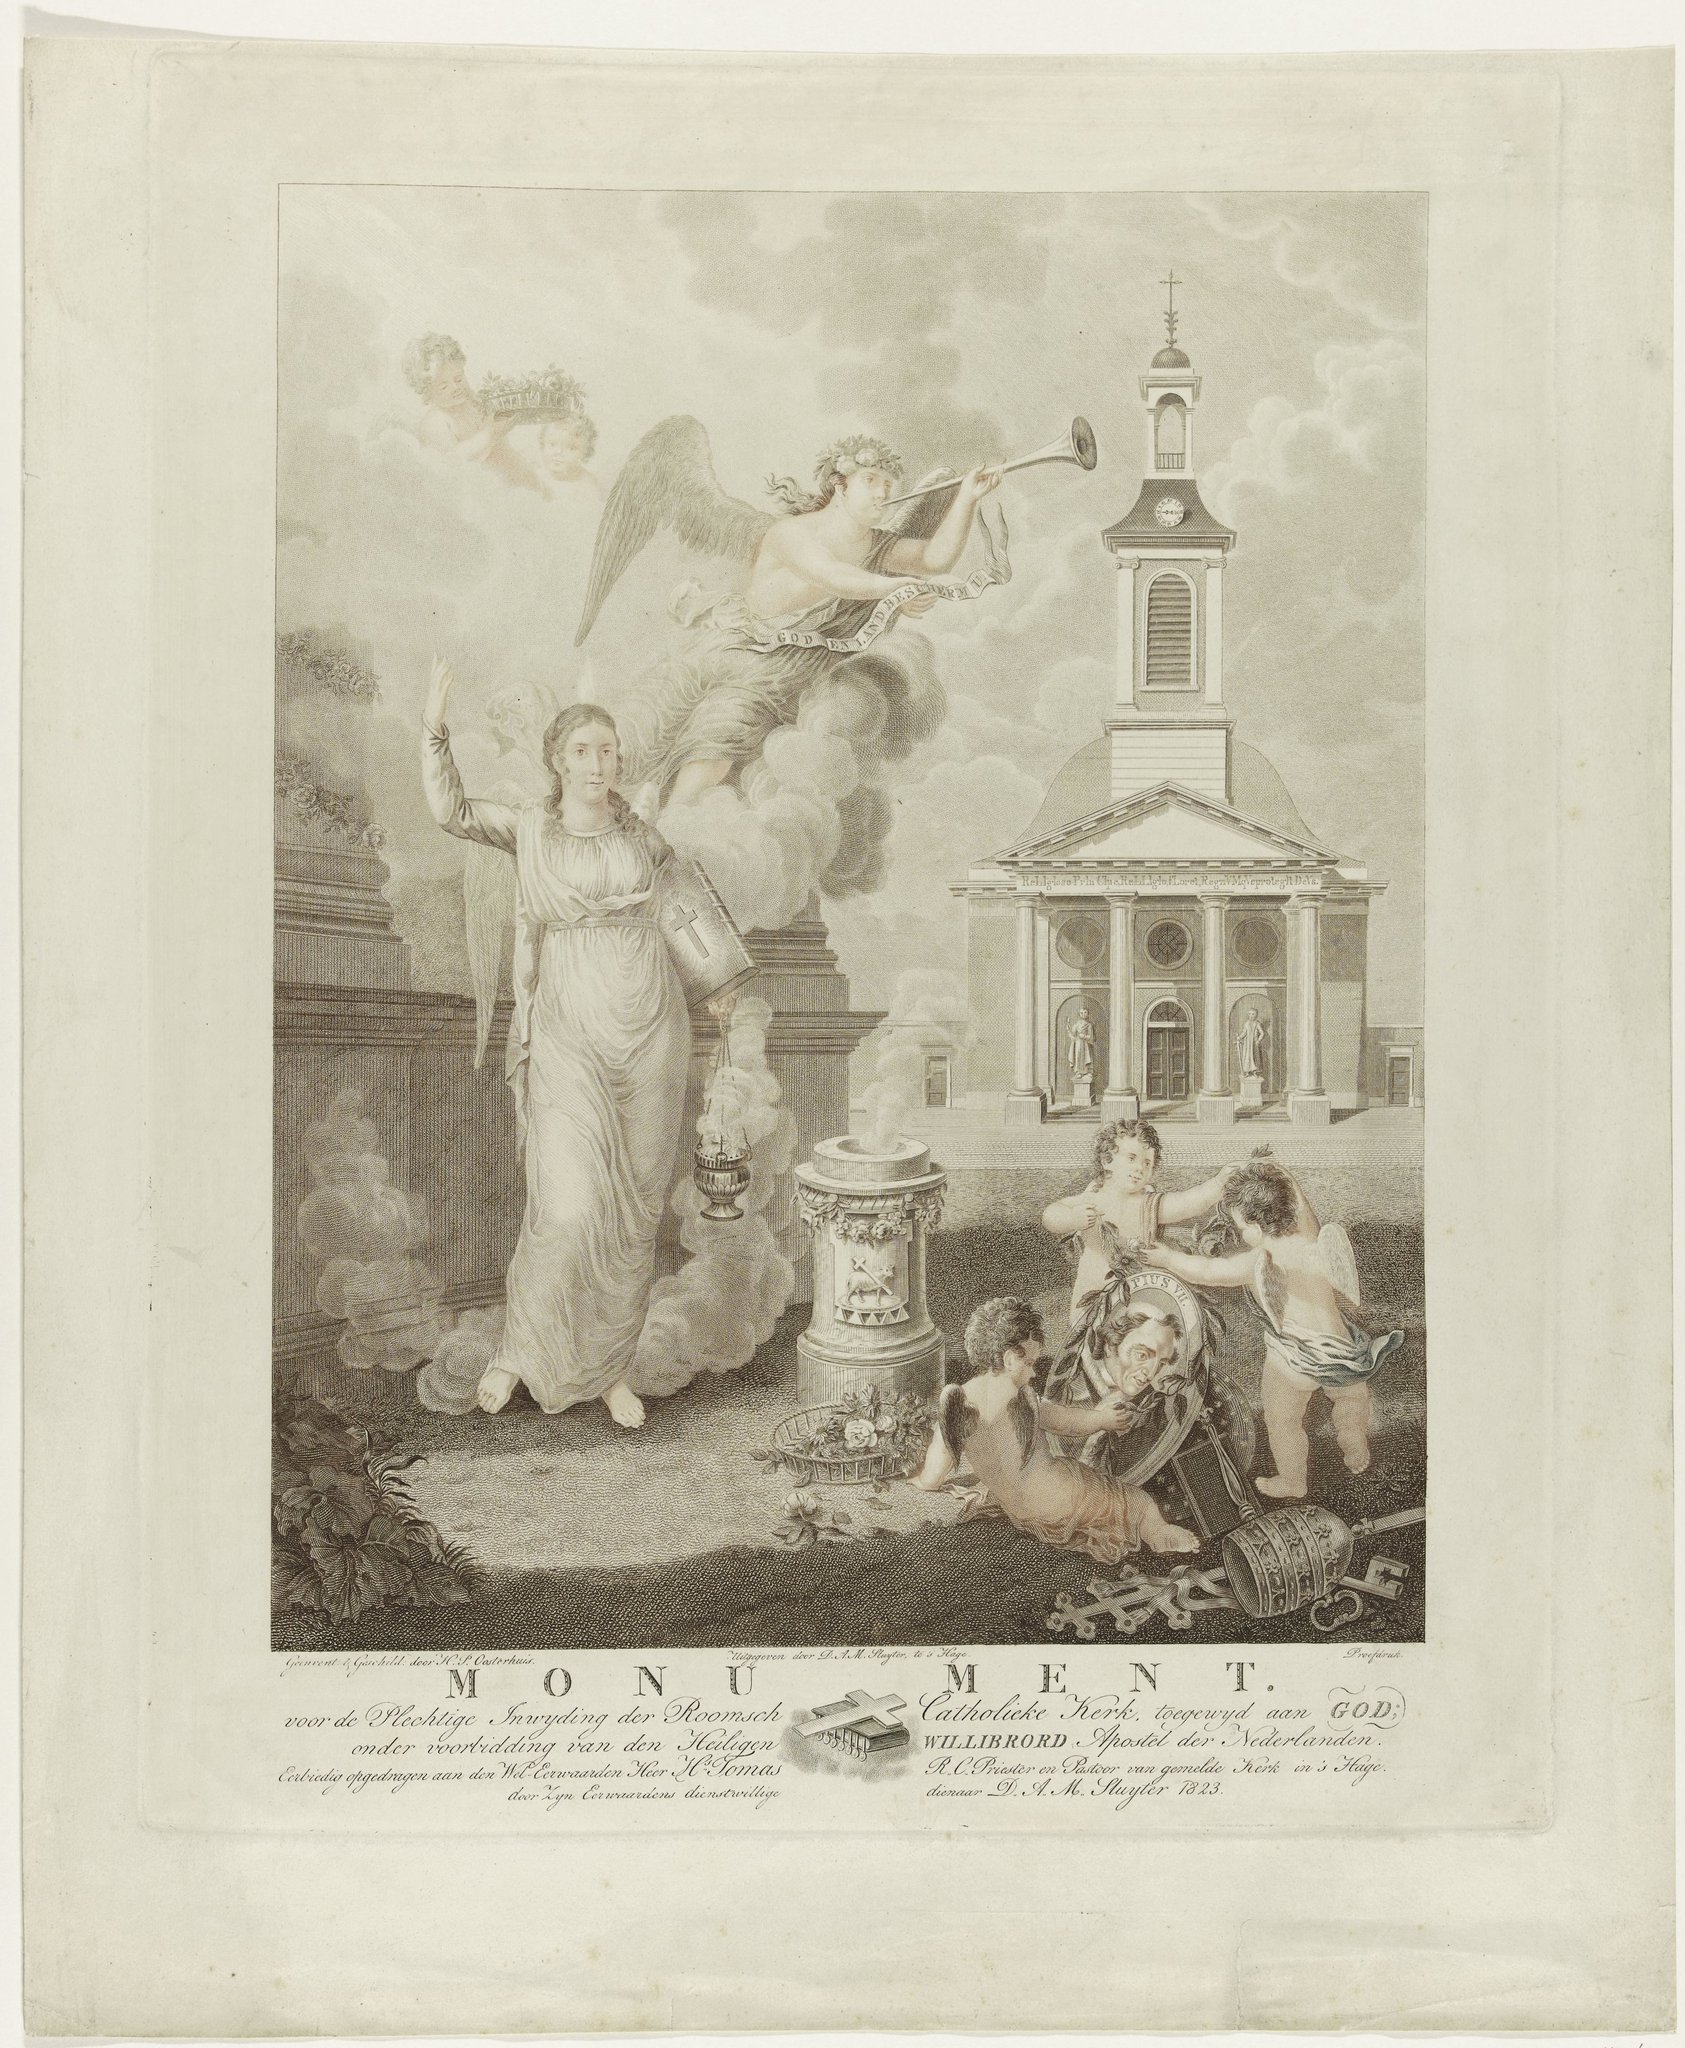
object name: print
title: Monument voor de inwijding de Sint-Willibrorduskerk te Den Haag, 1823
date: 1823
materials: paper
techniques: engraving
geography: the hague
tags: rome, clergyman, pius vii, church (exterior), allegorical representations ~ religion; 'religione', 'religione de ss. mauritio e lazaro', 'religione vera christiana' (ripa), fame; 'fama', 'fama buona', 'fama chiara' (ripa)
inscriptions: collector's mark: Lugt 2228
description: Allegorisch monument bij de inwijding van de Sint-Willibrorduskerk te Den Haag in 1823. Naast een brandend altaar staat de Godsdienst met wierookvat, in de lucht de Faam, rechts drie putti die een portret van paus Pius VII met bloemen versieren. Op de achtergrond de nieuwe kerk.